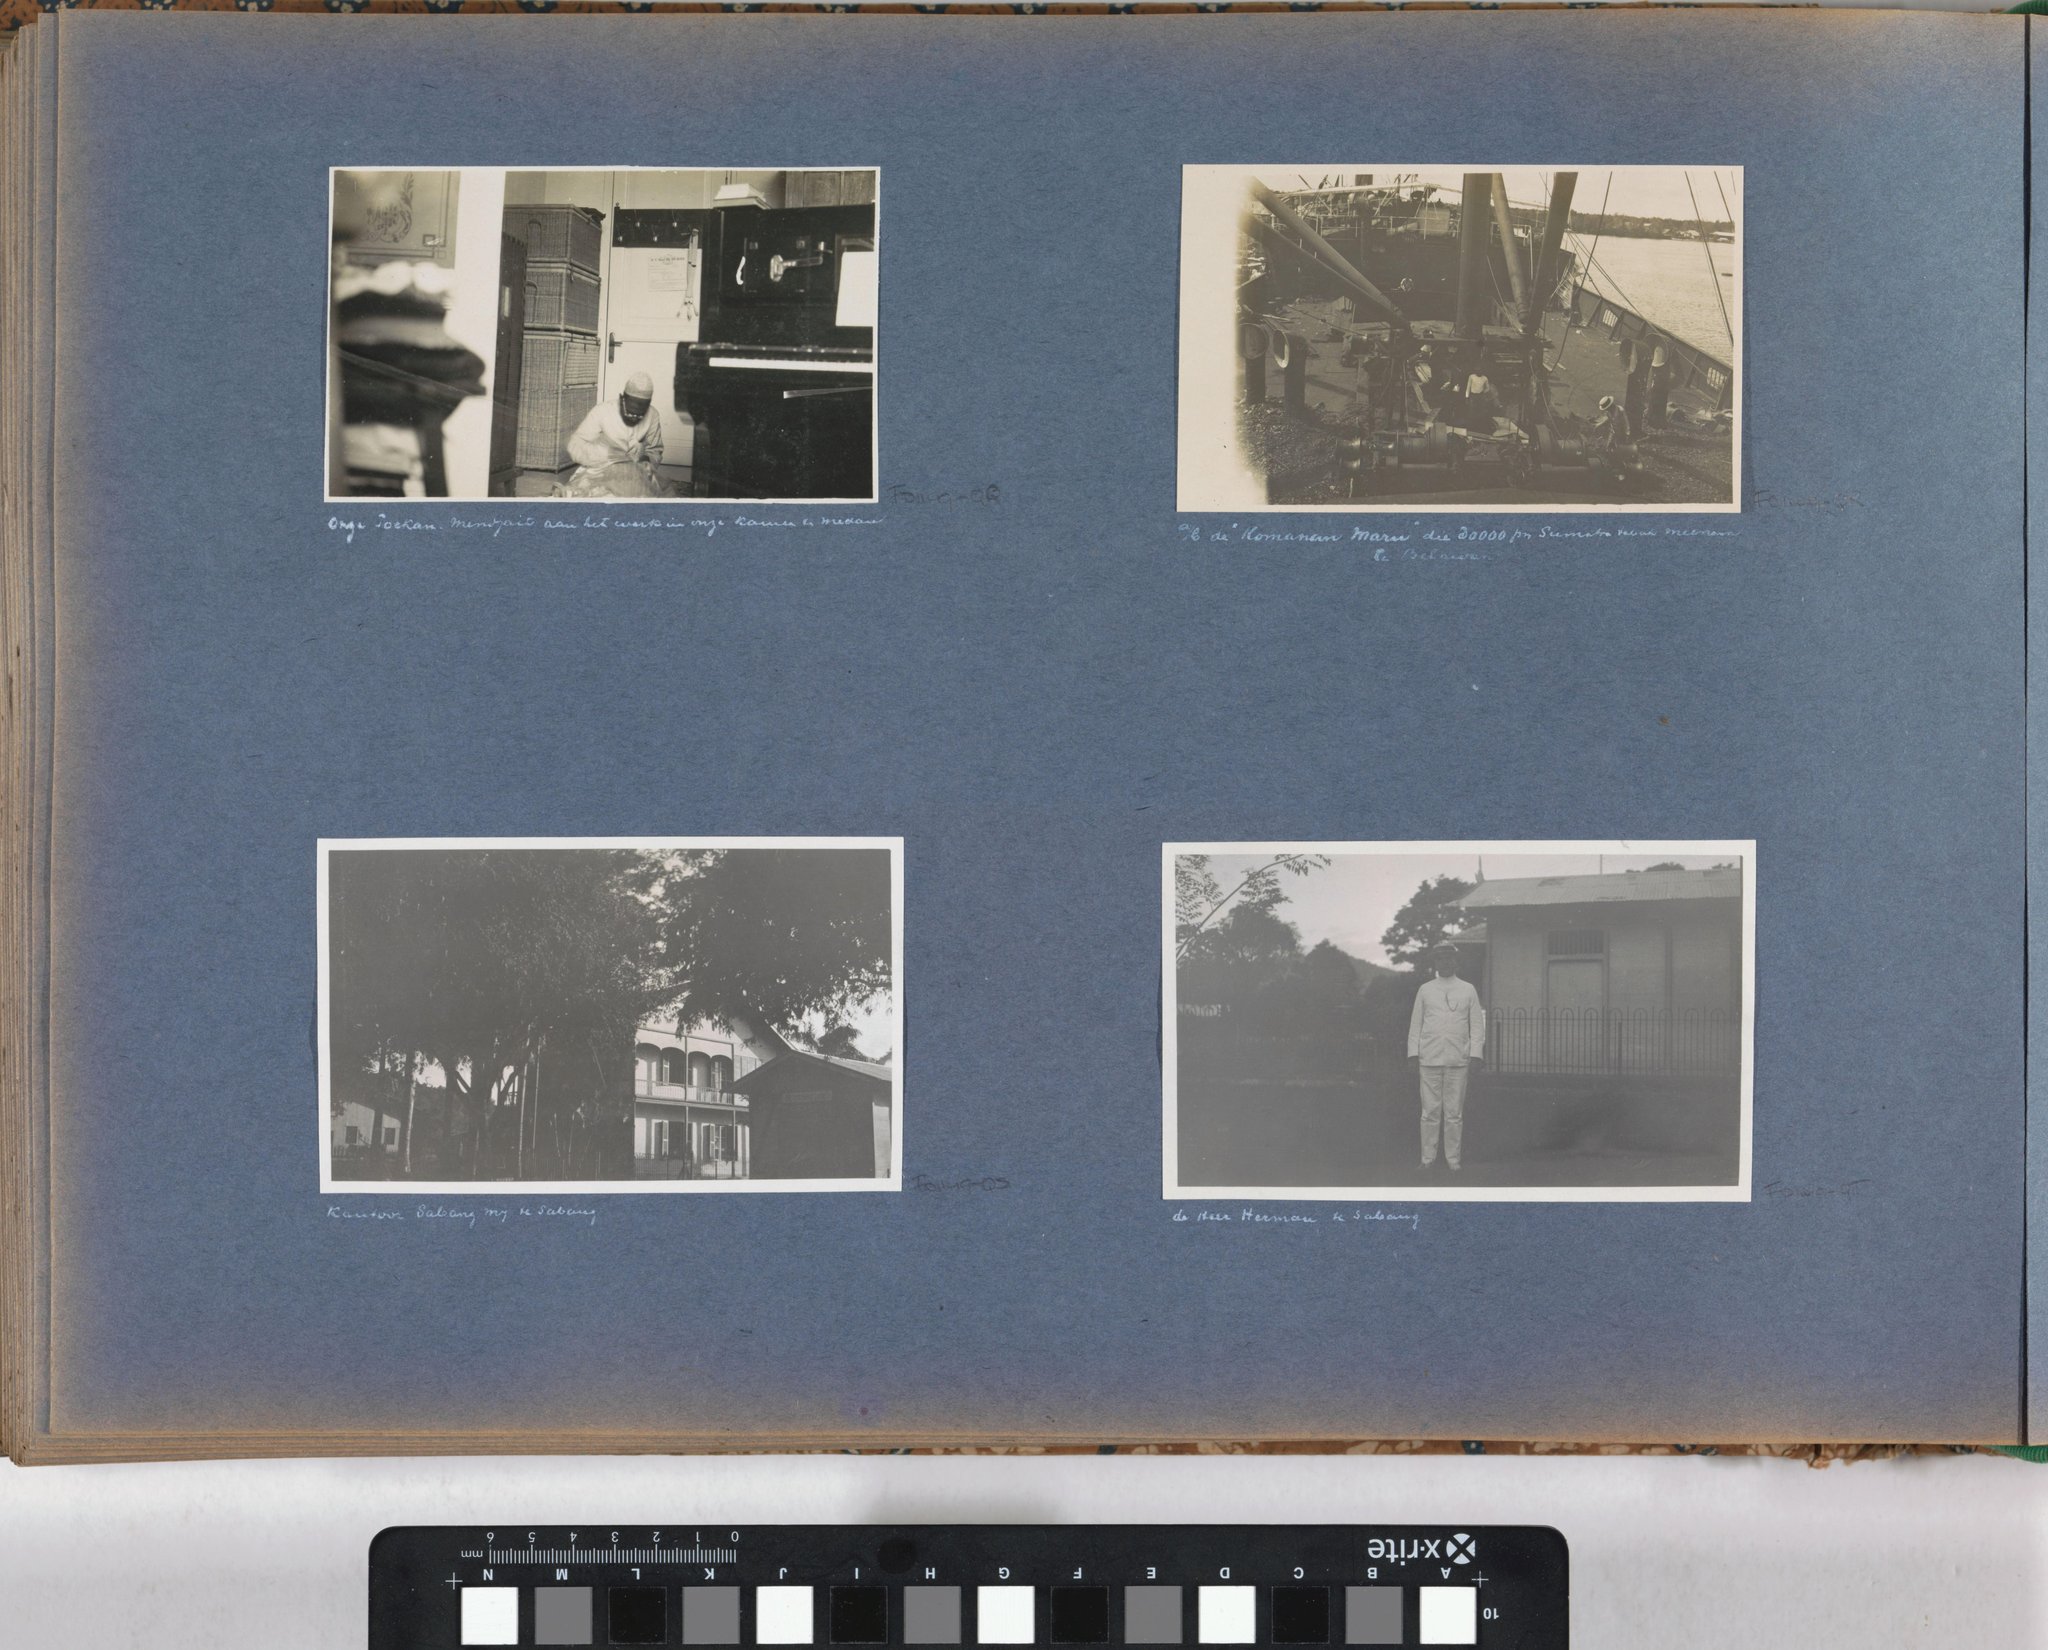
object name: photograph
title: Portret van een man aangeduid als 'de Heer Herman' voor een gebouw te Sabang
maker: Anonymous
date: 1900-1920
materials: paper, photographic support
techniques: gelatin silver print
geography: sabang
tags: adult man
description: Onderdeel van reisalbum met foto's van bedrijvigheid en bezienswaardigheden op Sumatra en Java en van de reis naar en van Nederlands-Indië.